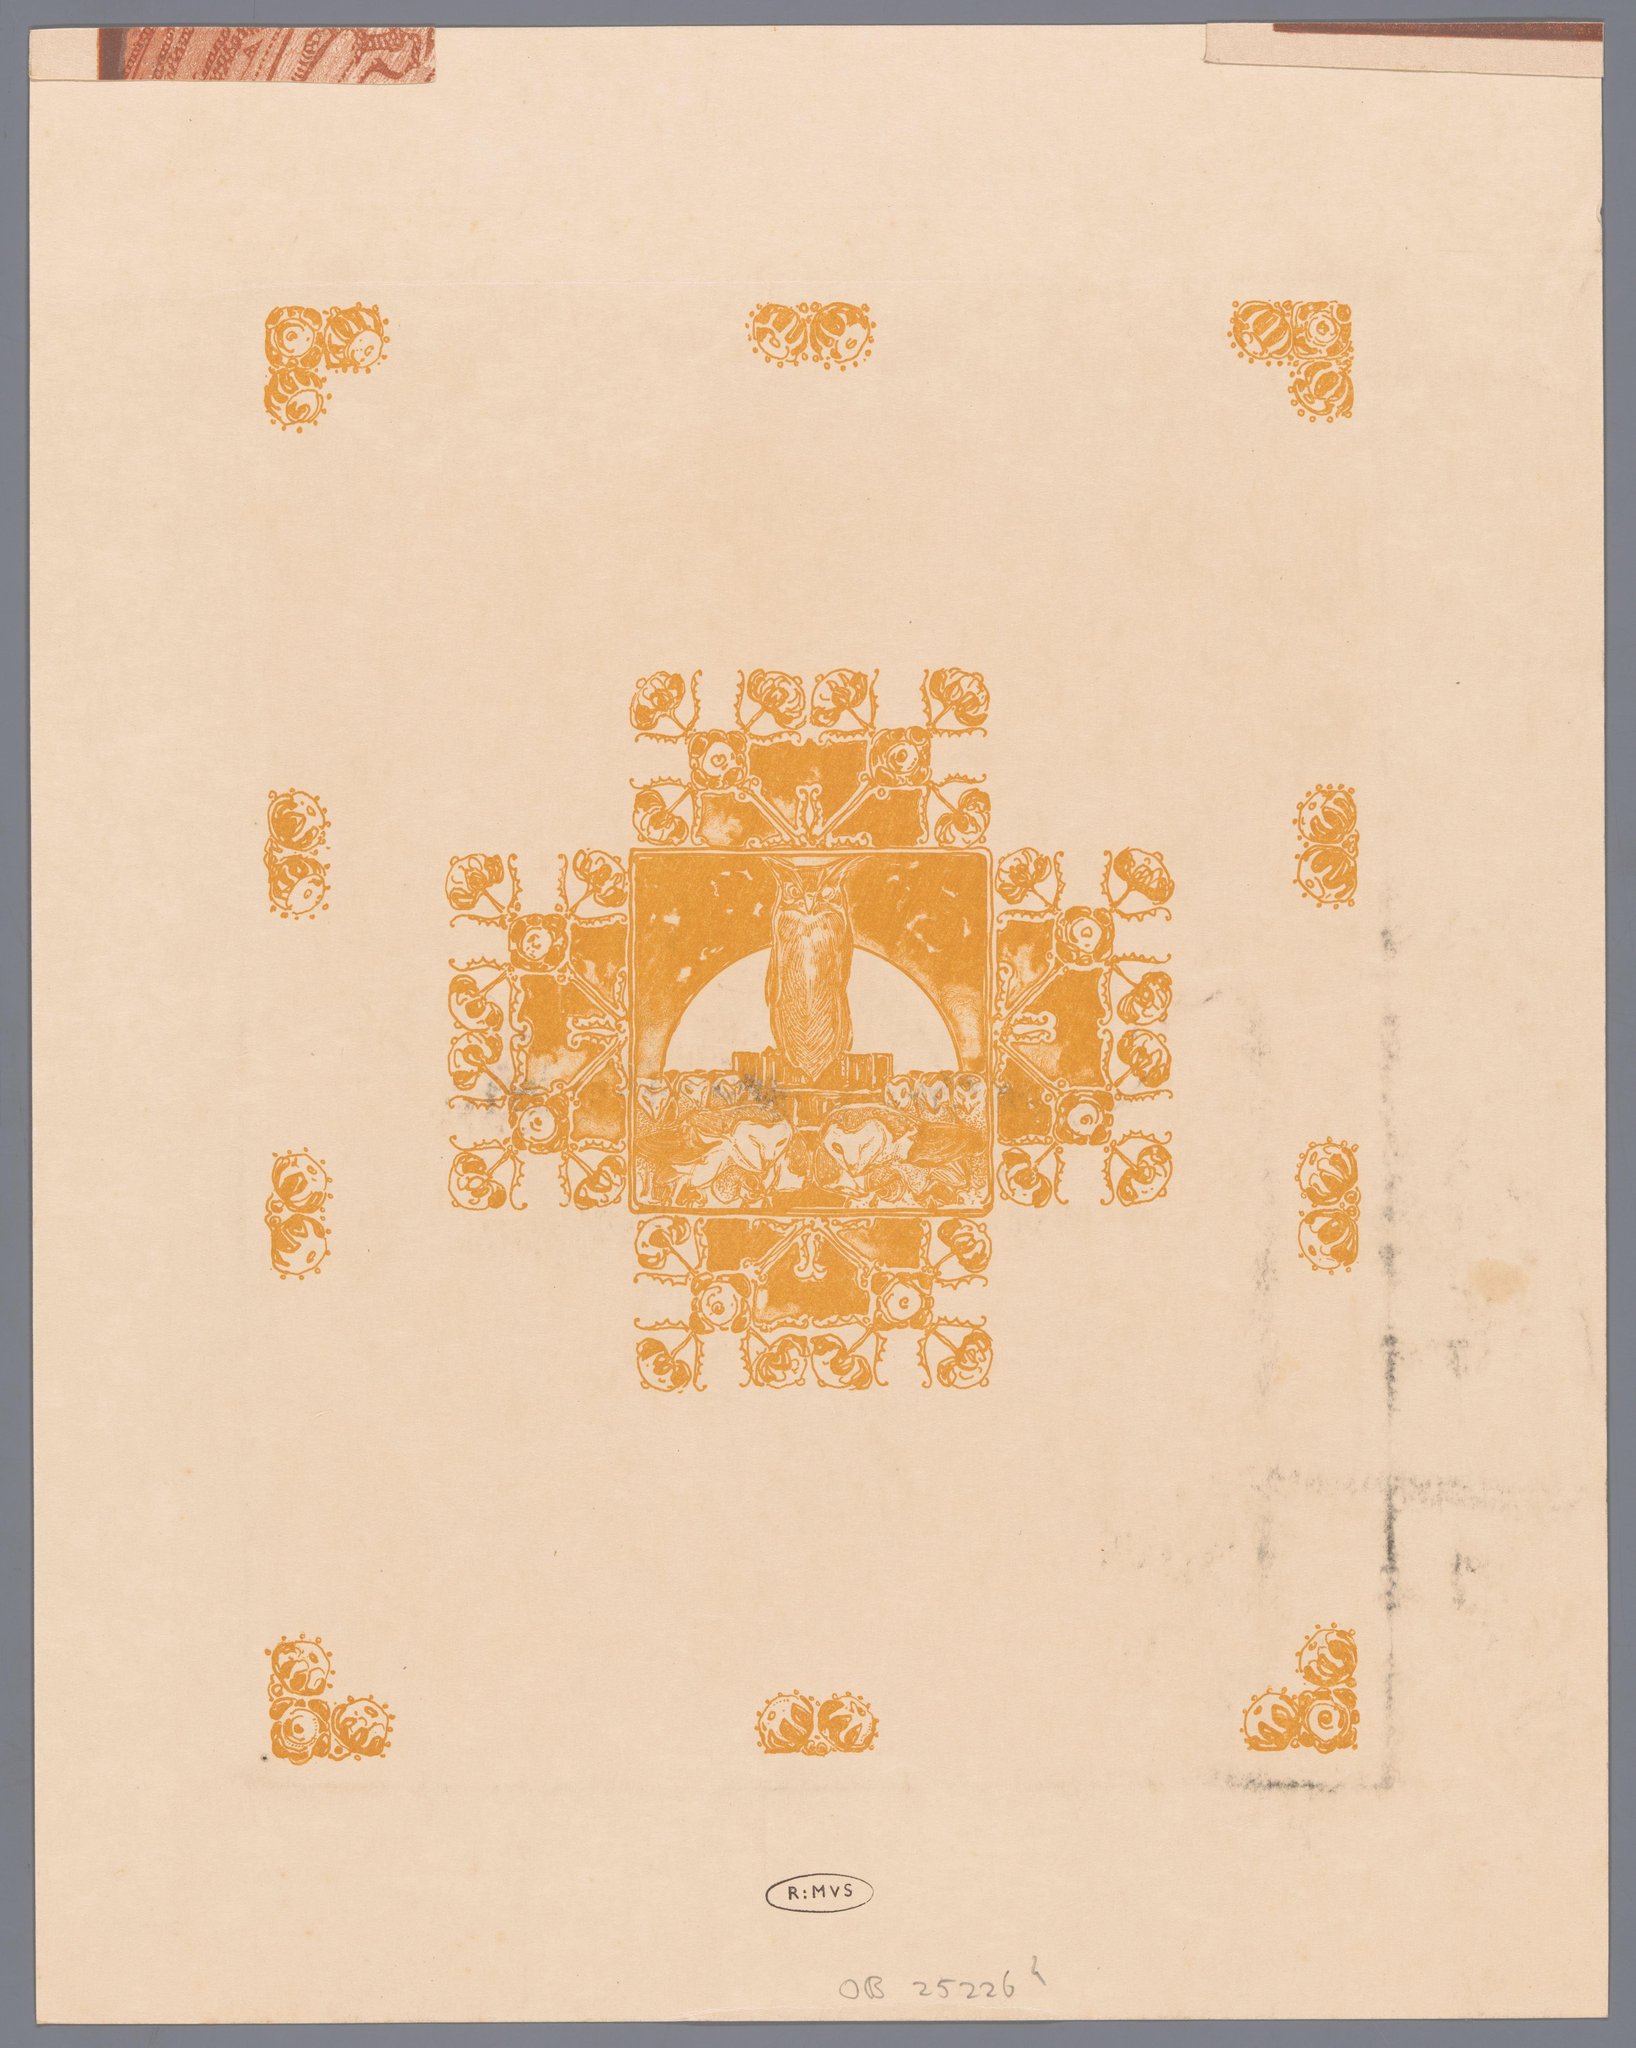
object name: print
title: Ornamentiek en uilen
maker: bernard willem wierink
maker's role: draughtsman, print maker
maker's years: 1856-1939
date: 1910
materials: paper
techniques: lithograph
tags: fable of reynard the fox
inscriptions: collector's mark: Lugt 2228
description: Prent gebruikt in: Streuvels, Stijn (Frank Lateur). Reinaert de Vos naar verschillende uitgaven van het middeleeuwsche epos. Amsterdam: L.J. Veen, 1910.